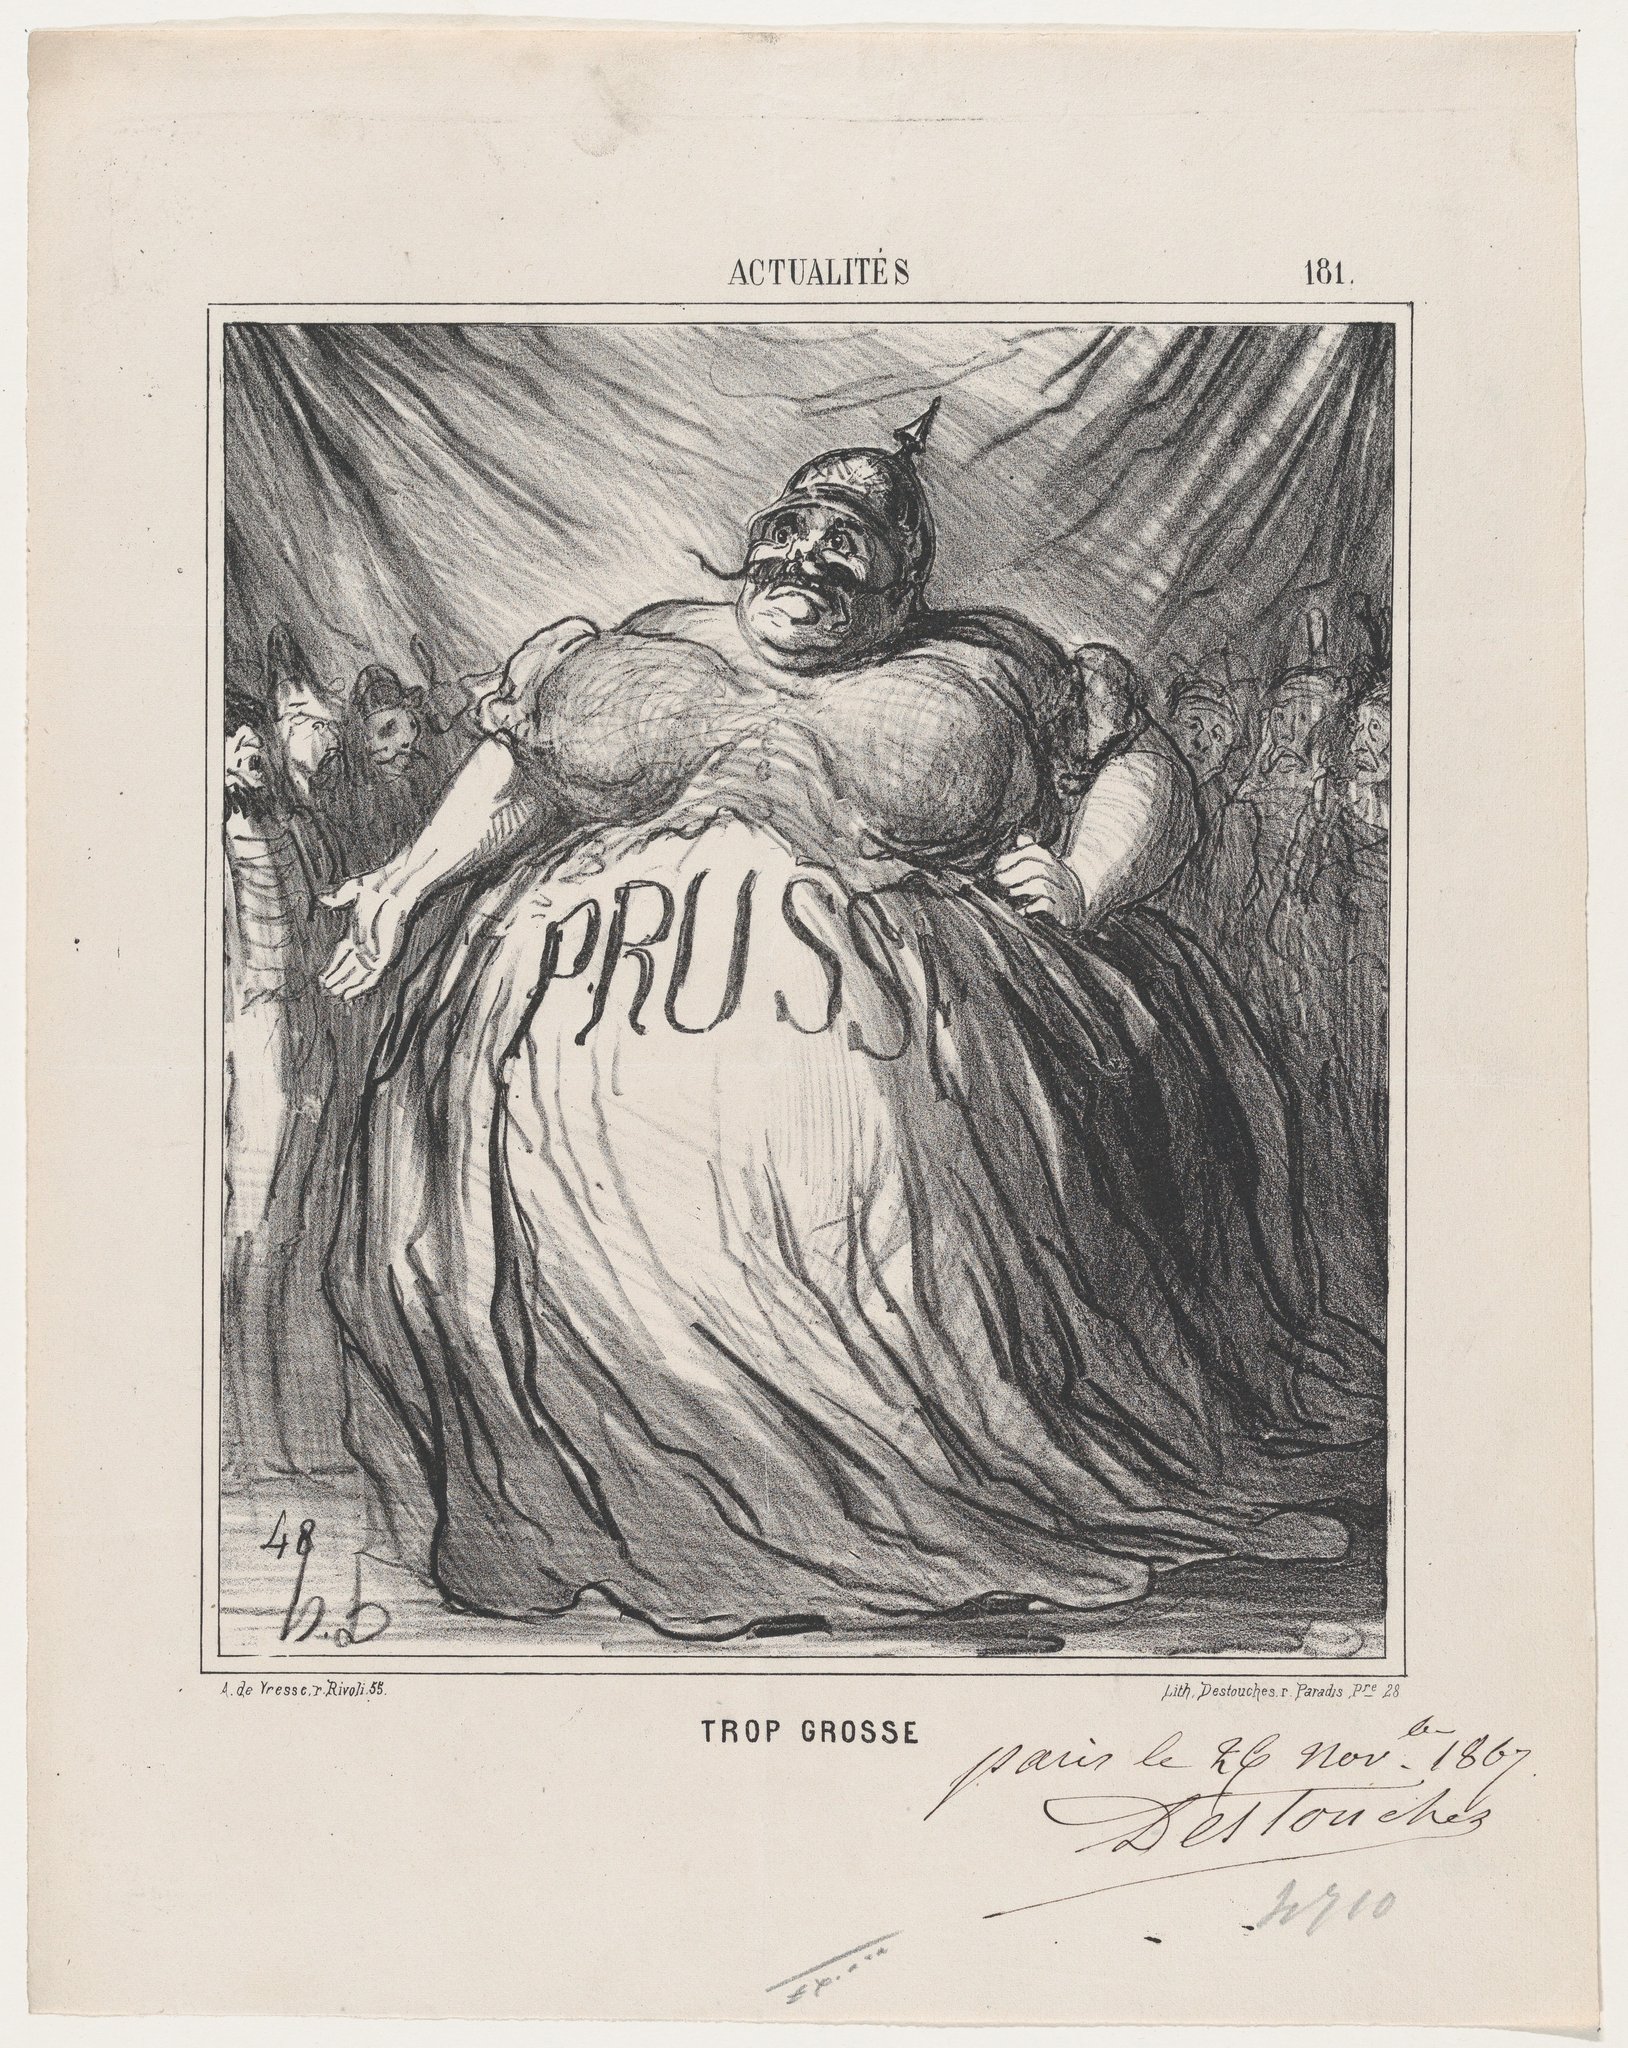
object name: print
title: Too fat, from 'News of the day,' published in Le Charivari, November 16, 1867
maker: honoré daumier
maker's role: artist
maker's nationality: french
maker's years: 1808-1879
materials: ink, paper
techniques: lithograph, pen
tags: satire,men